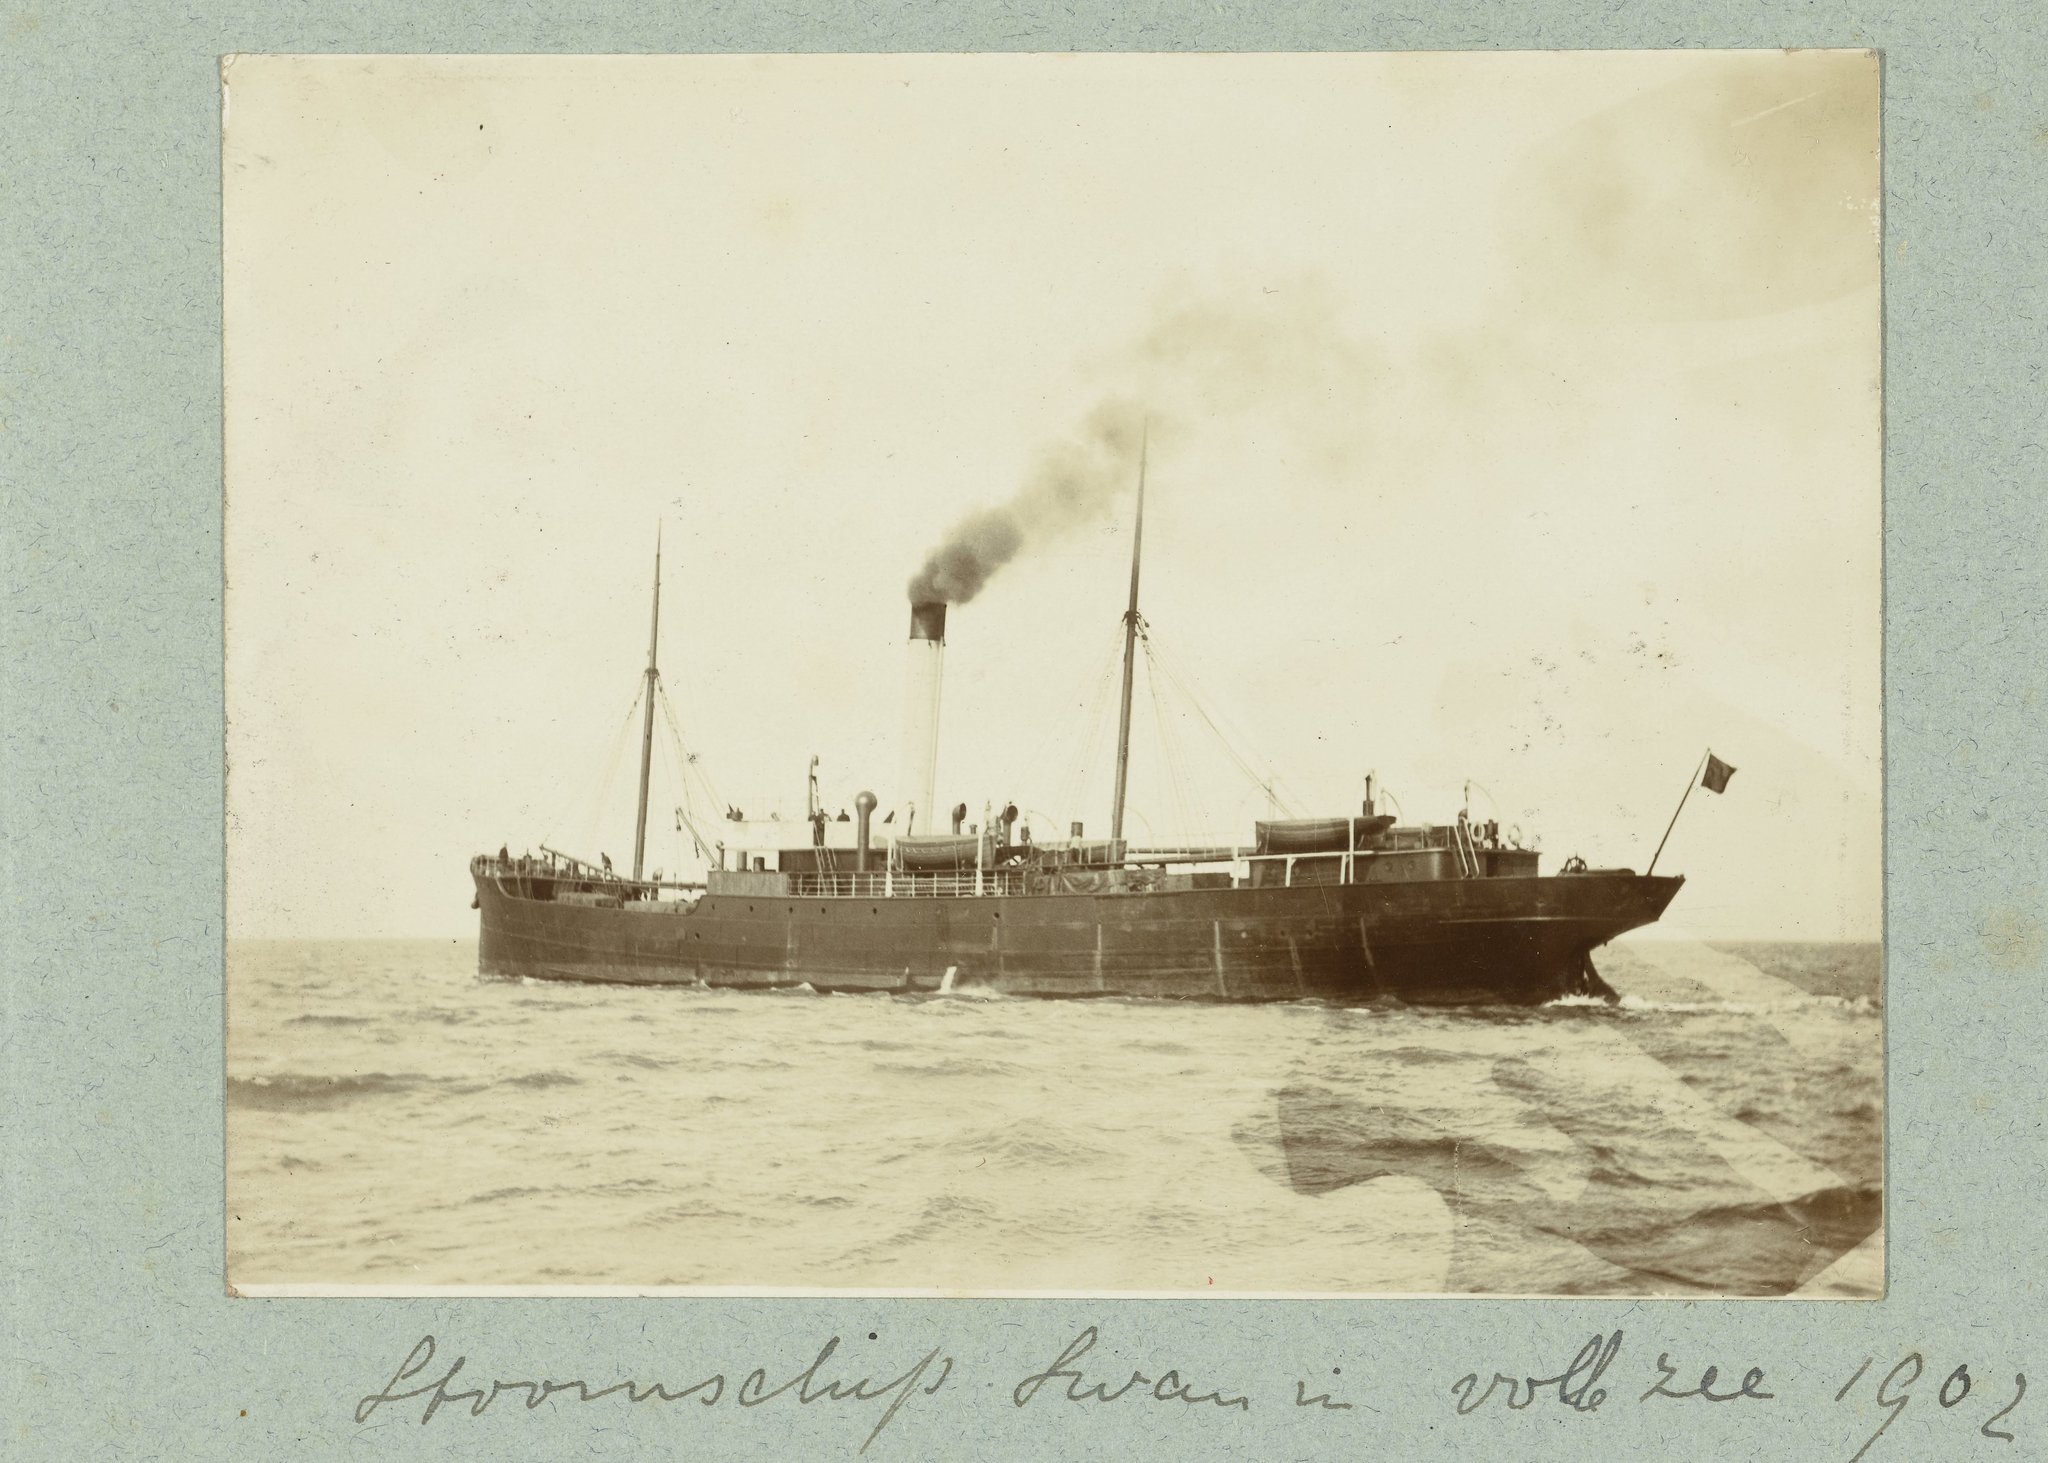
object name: photograph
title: Stoomschip Swan op zee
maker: frits freerks fontein fz.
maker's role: fotograaf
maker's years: 1882-1928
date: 1902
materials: cardboard, paper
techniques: gelatin silver print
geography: england